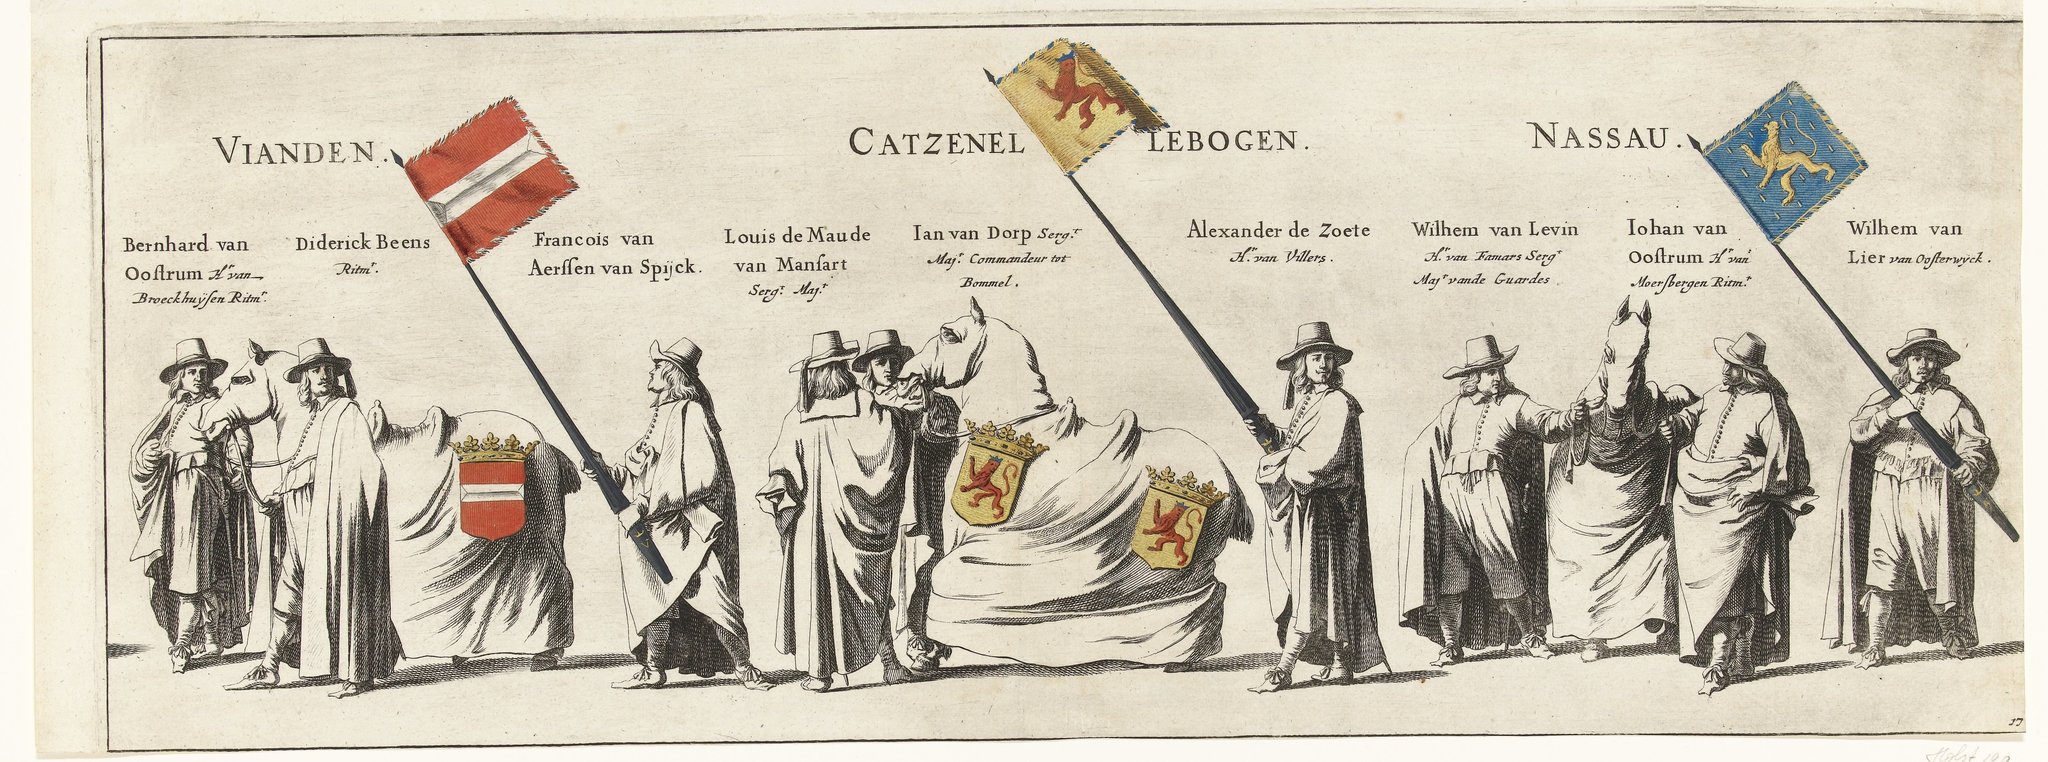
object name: print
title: De begrafenisstoet van stadhouder Frederik Hendrik te 's-Gravenhage in 1647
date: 1647-1651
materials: paper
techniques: etching, hand coloring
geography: amsterdam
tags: the hague, frederick henry (prince of orange), cortege, funeral procession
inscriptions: collector's mark: Lugt 2228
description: De begrafenisstoet van stadhouder Frederik Hendrik te 's-Gravenhage op 10 mei 1647. Plaat nr. 17 met een deel van de stoet met vaandeldragers en drie paarden, boven de personen staan hun naam en functie. Onderdeel van een serie van 30 platen en 20 tekstbladen, bedoeld om aan elkaar geplakt te worden.